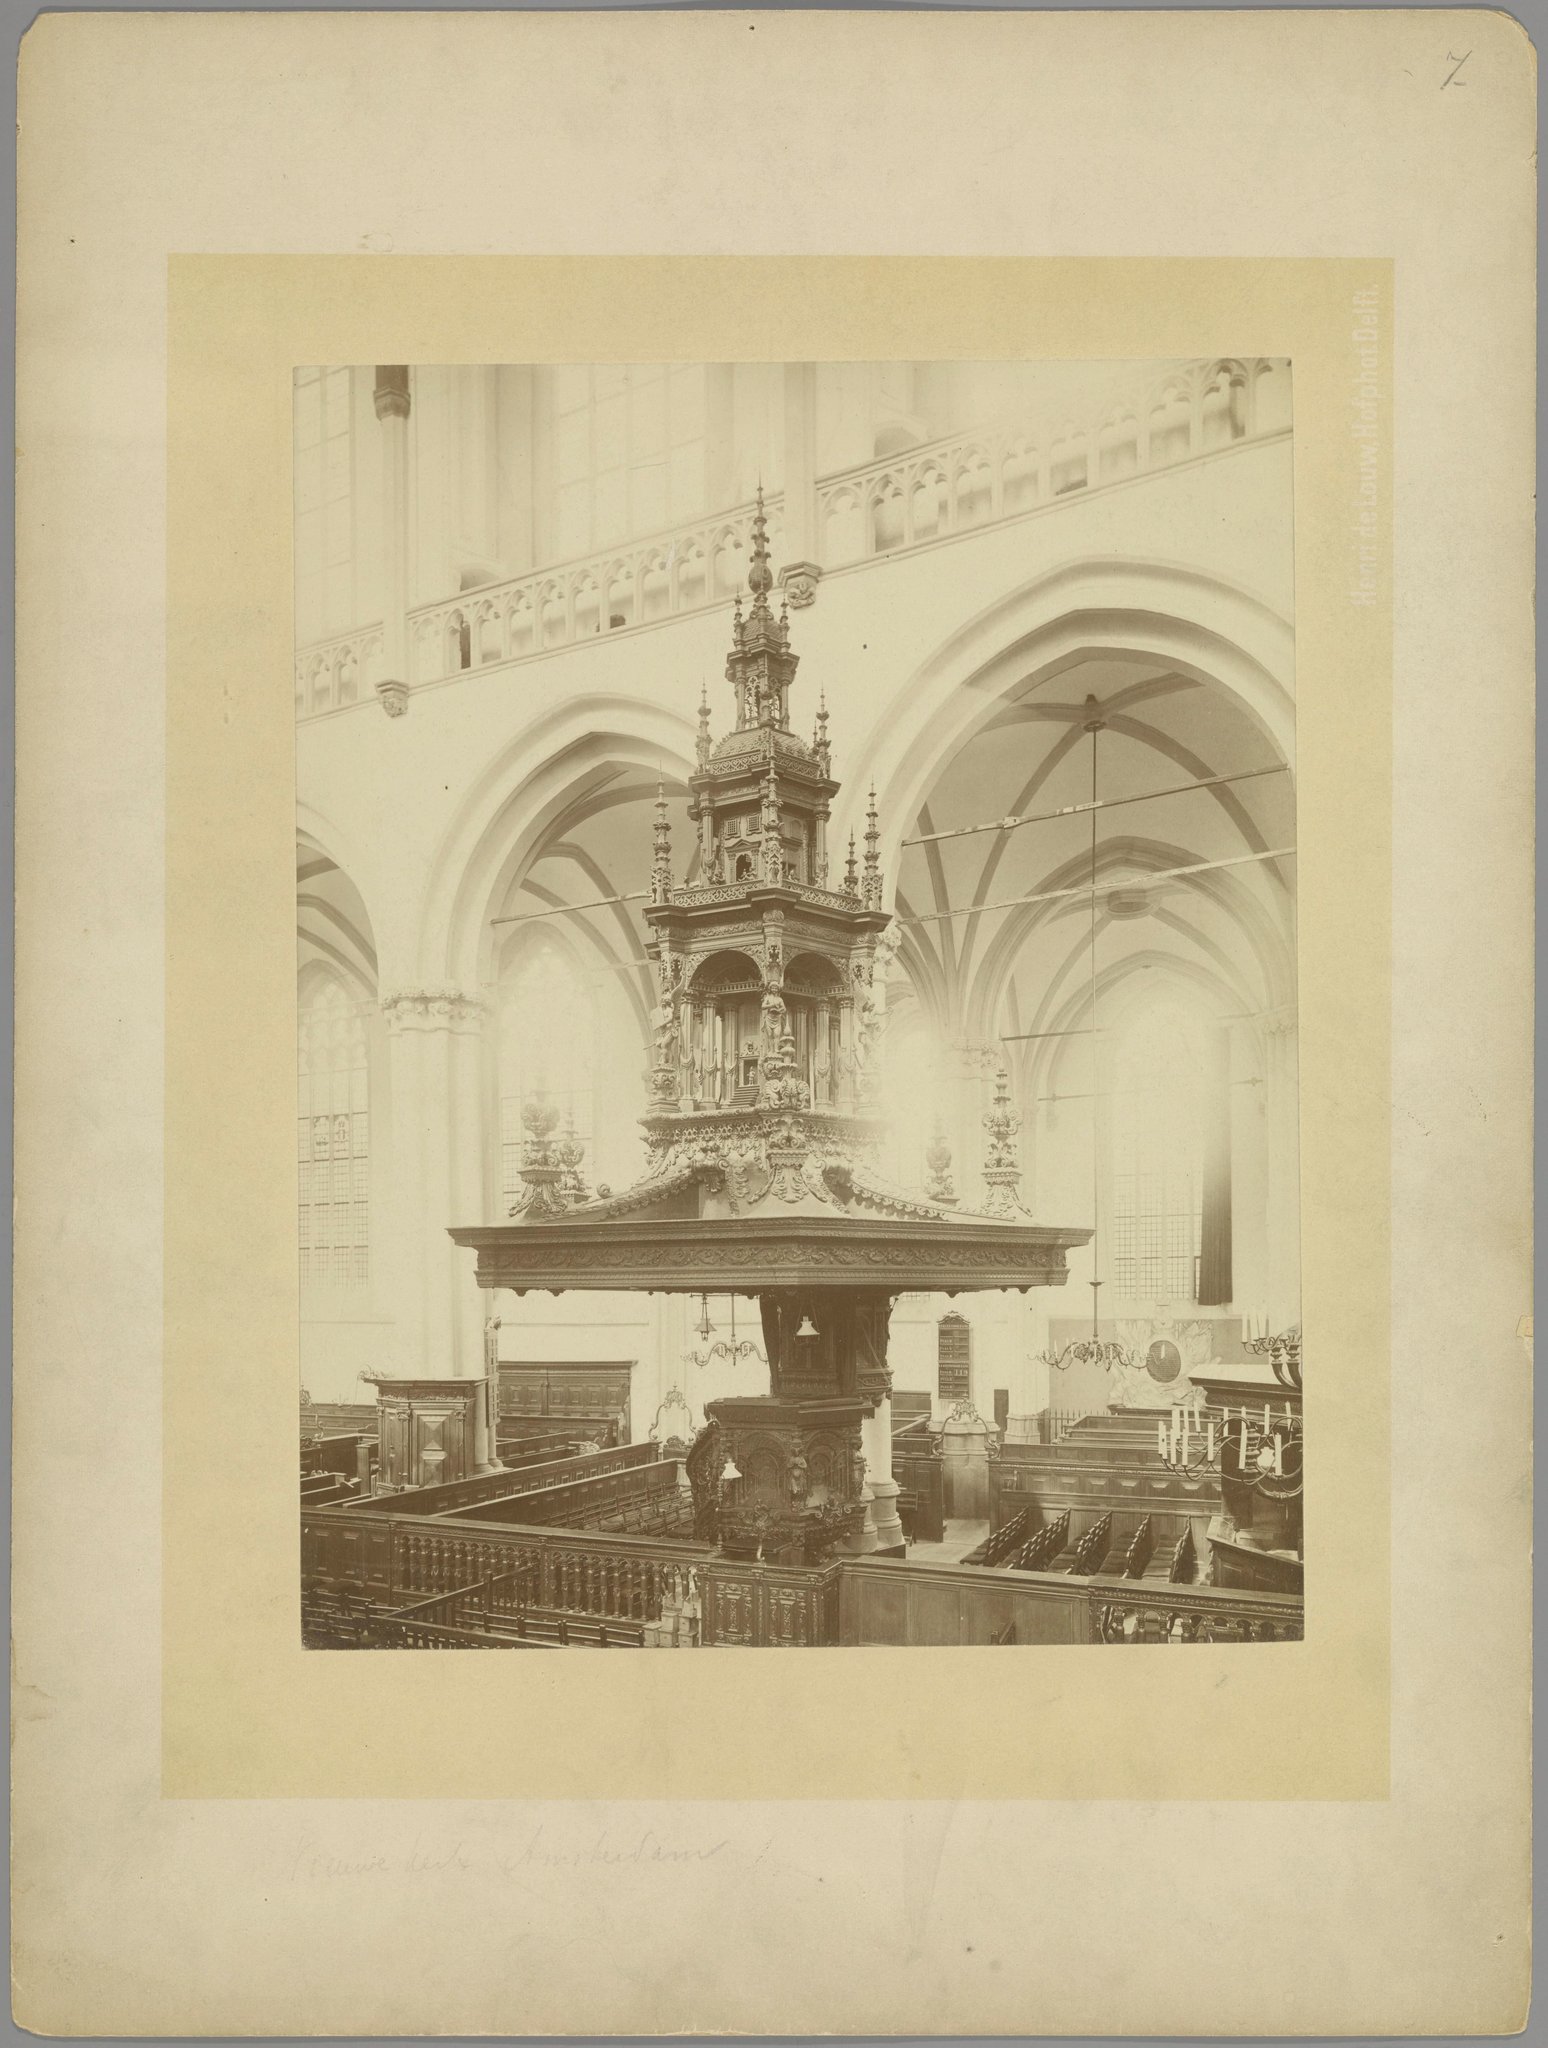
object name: photograph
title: Preekstoel van de Nieuwe Kerk te Amsterdam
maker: henri de louw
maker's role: fotograaf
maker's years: 1851-1944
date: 1875-1900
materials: cardboard, photographic support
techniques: albumen print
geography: nieuwe kerk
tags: parts of church interior, pulpit, ambo, chancel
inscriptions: collector's mark: Lugt 3937, name: ‘Henri de Louw, Hofphot. Delft.’, annotation